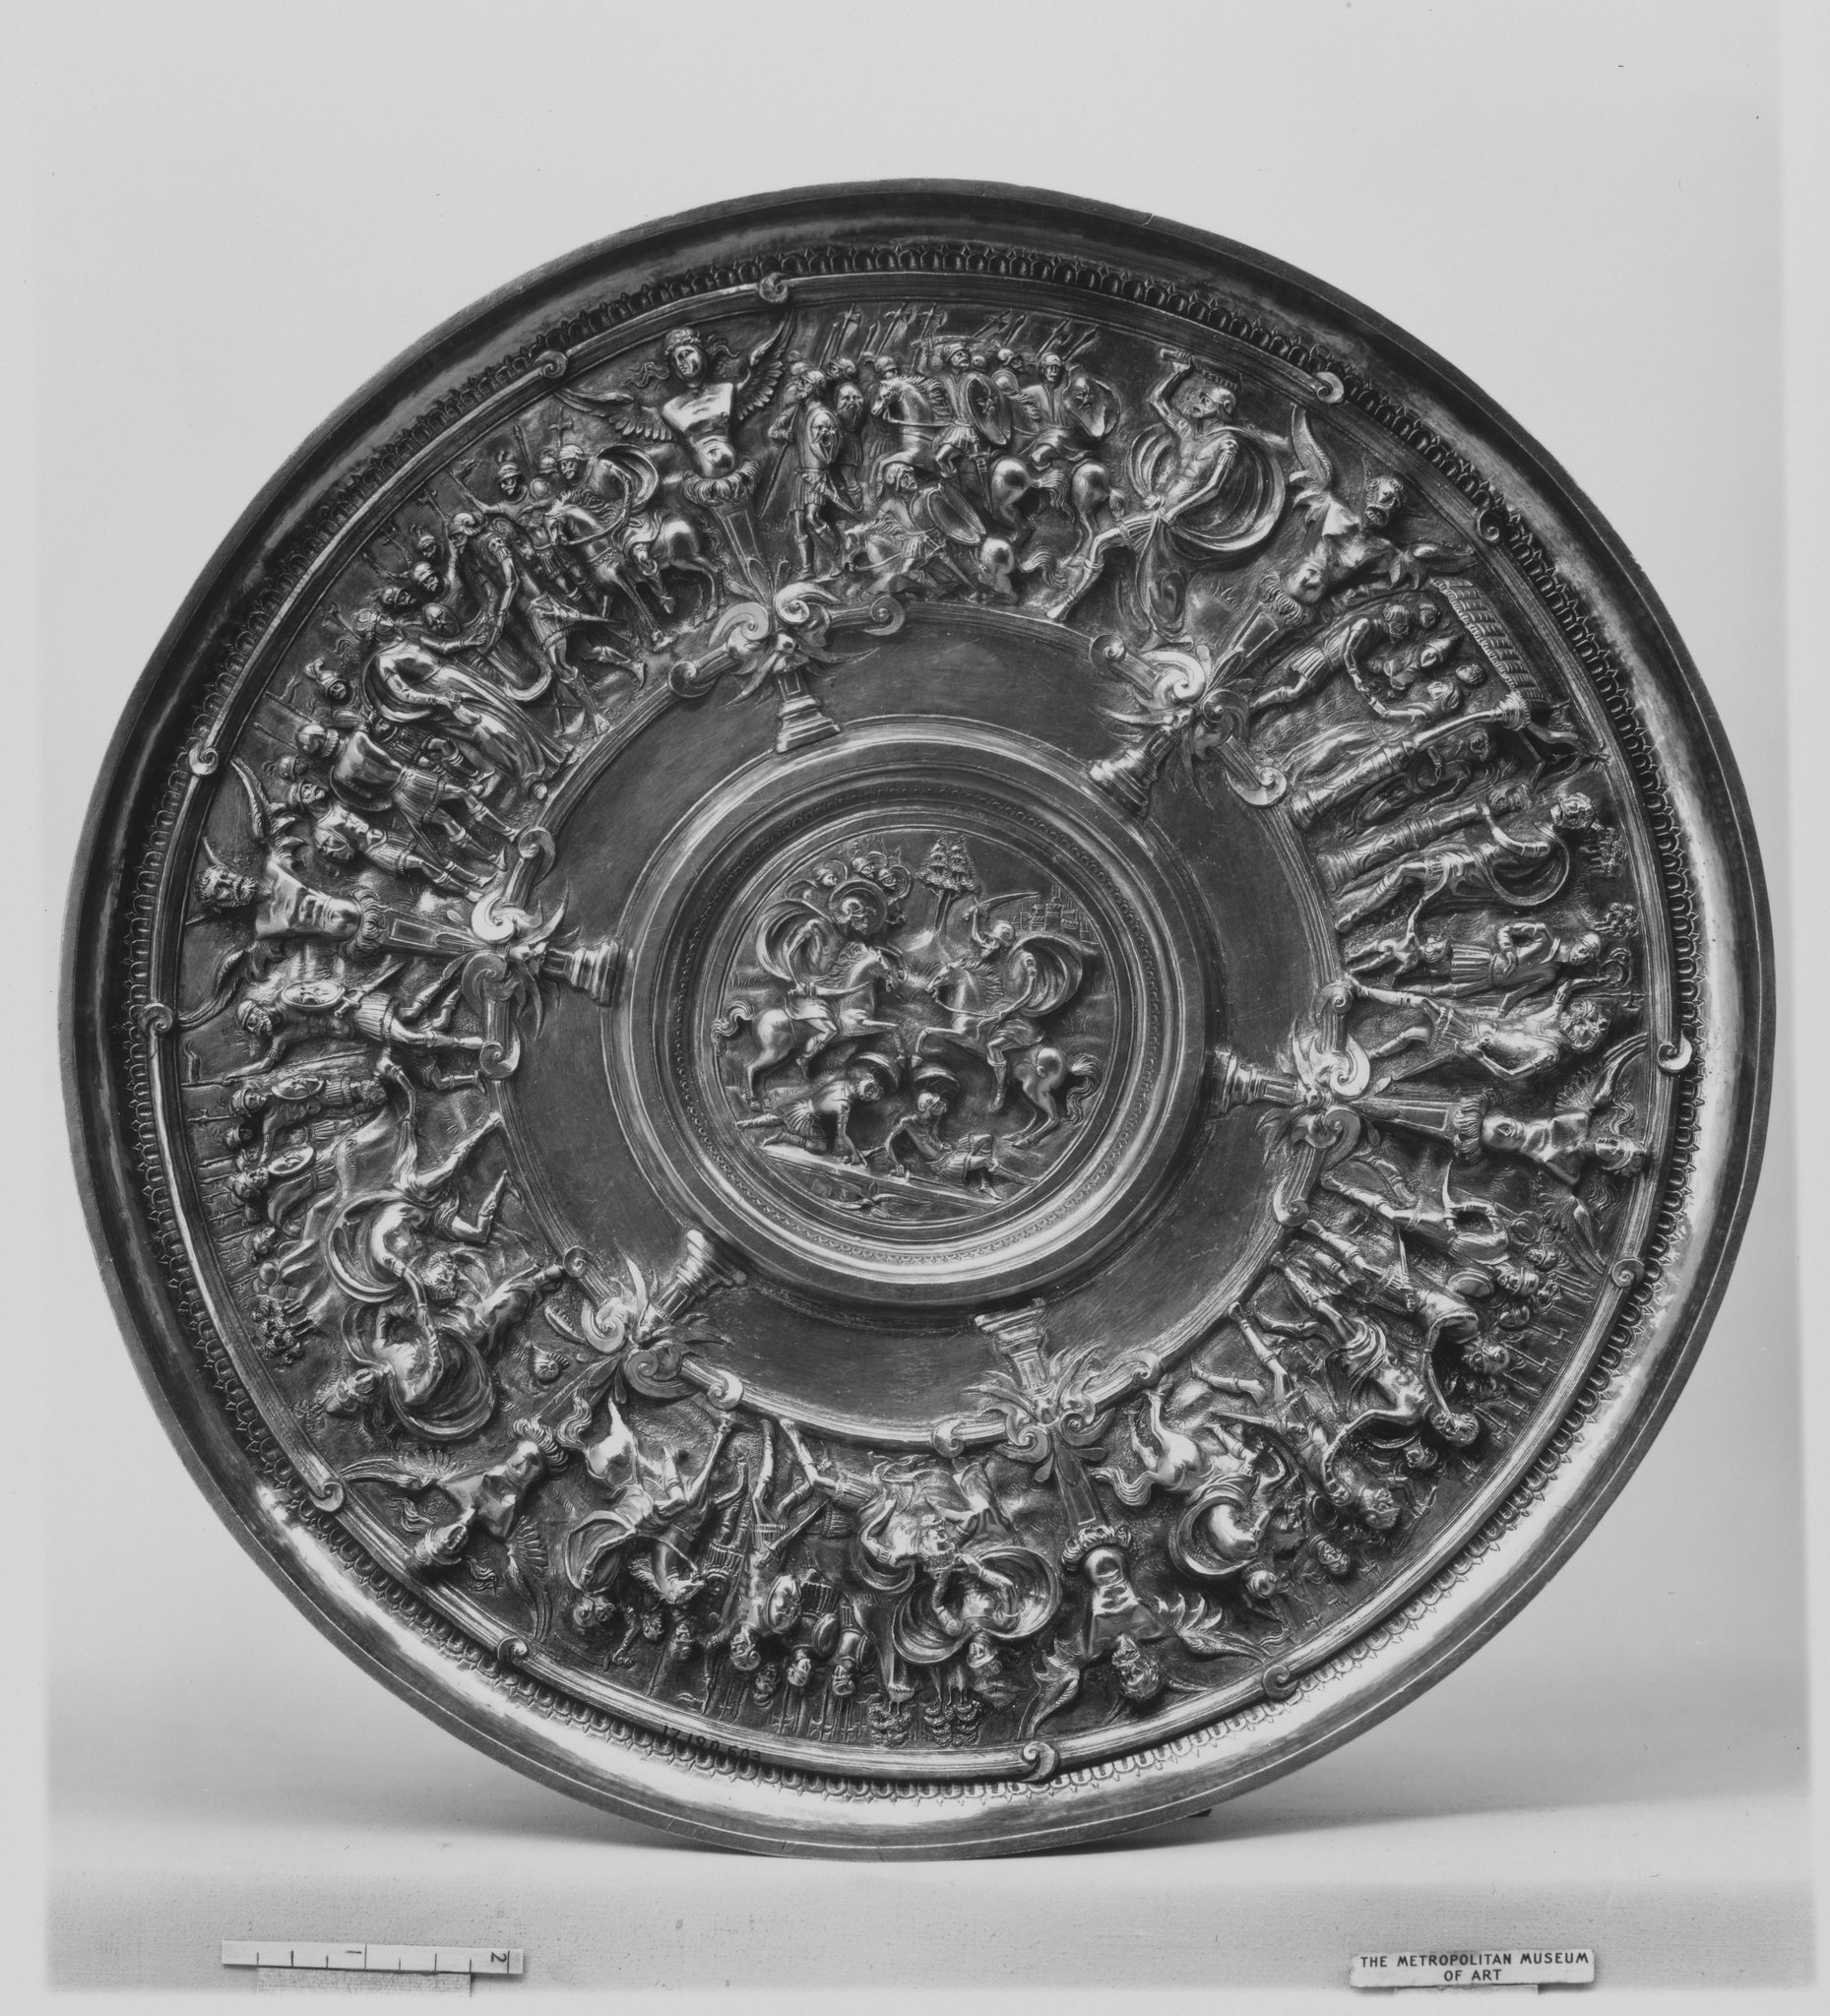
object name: dish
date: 1501-1600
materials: silver gilt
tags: battles,soldiers,horses